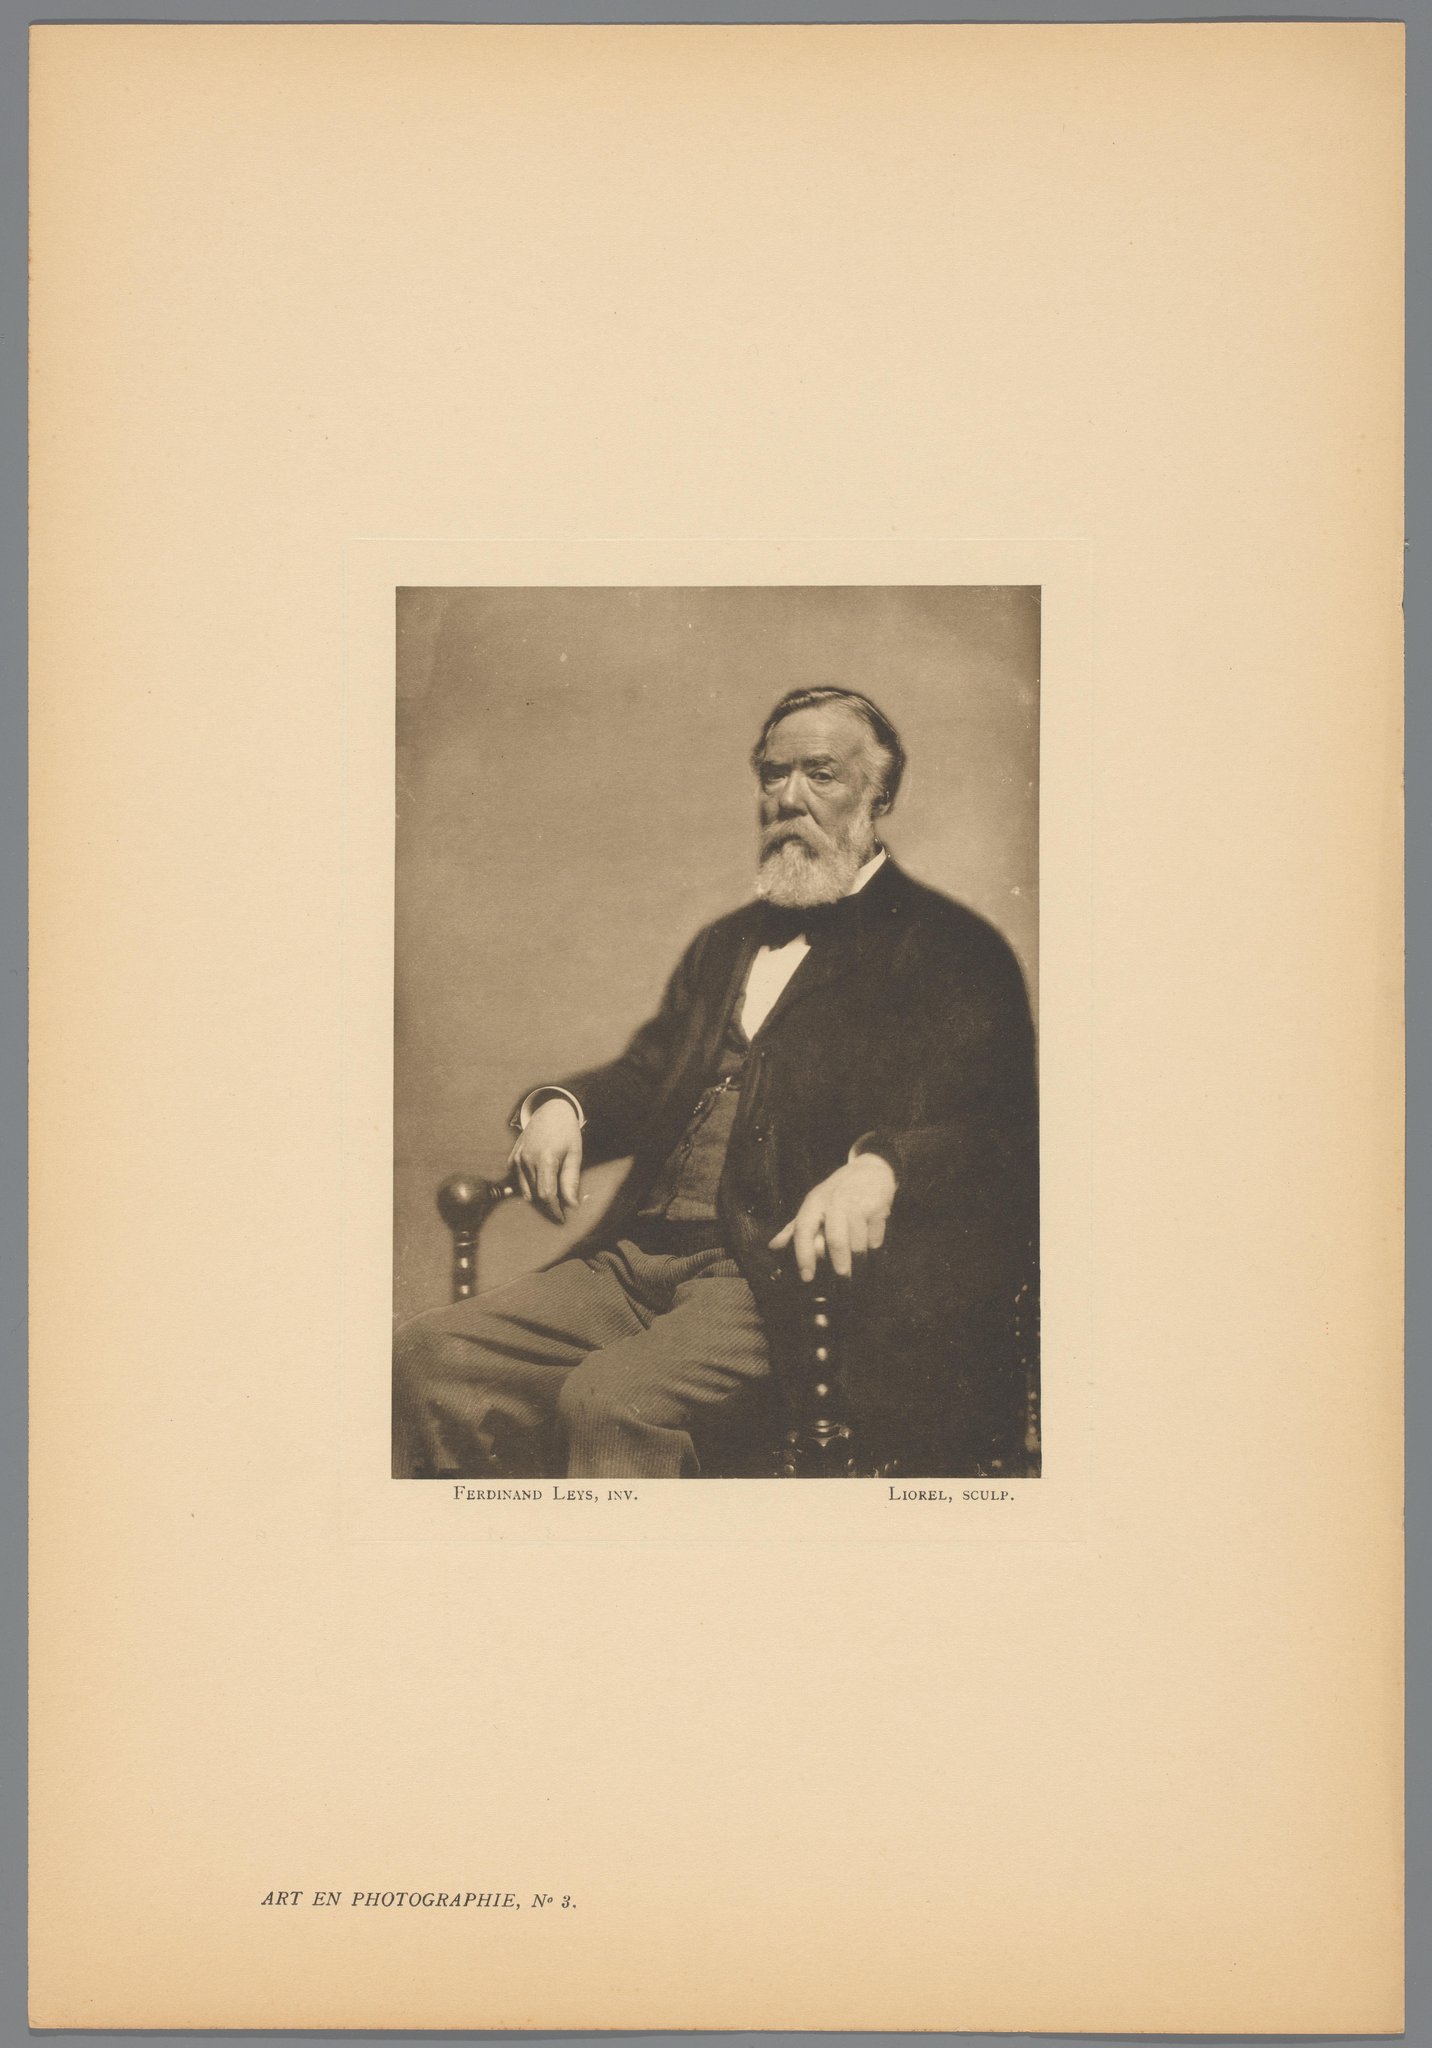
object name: photomechanical print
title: Portret van een onbekende man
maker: ferdinand leys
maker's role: fotograaf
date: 1896-1901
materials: paper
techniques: photograph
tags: historical persons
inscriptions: inscription: ‘ART EN PHOTOGRAPHIE, No 3.’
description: Deze prent maakt deel uit van een omslag met 54 prenten op 52 bladen.